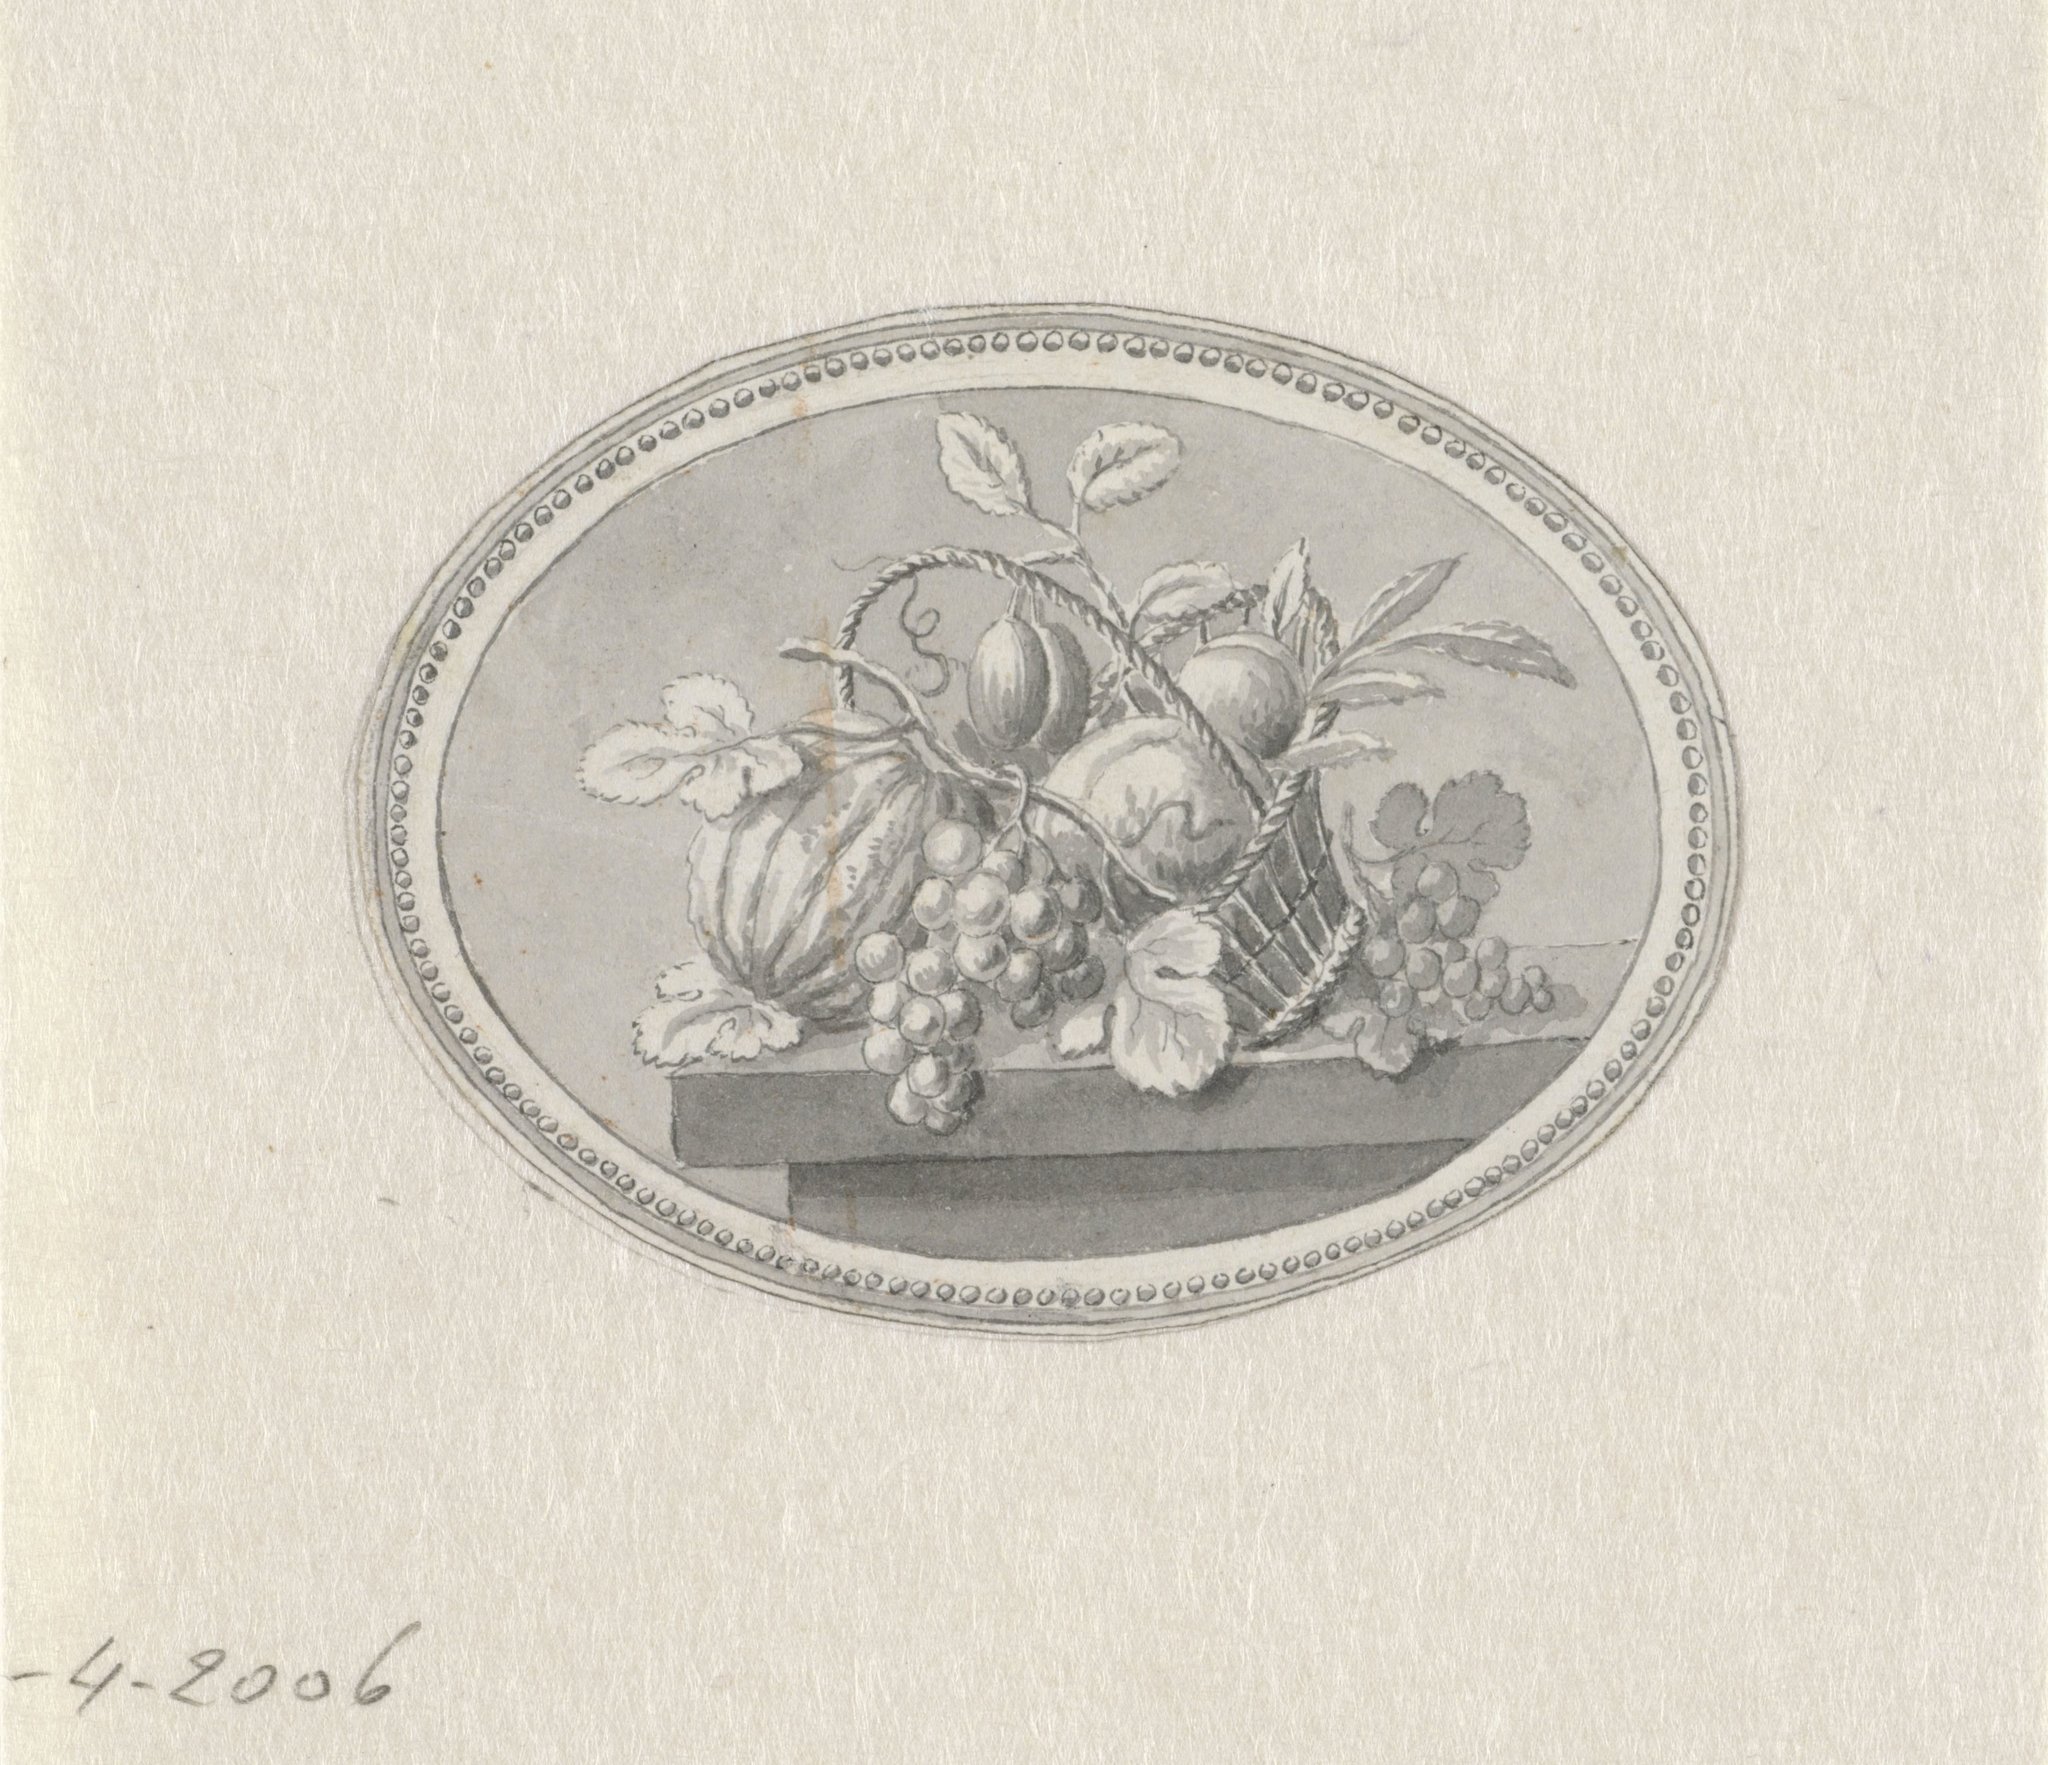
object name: drawing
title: Vignet met twee vogels die een nest bouwen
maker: pieter de goeje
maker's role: draughtsman, print maker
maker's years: 1789-1859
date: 1789-1859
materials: chalk, ink, paper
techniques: brush, pen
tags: birds (+ nest, den, burrow)